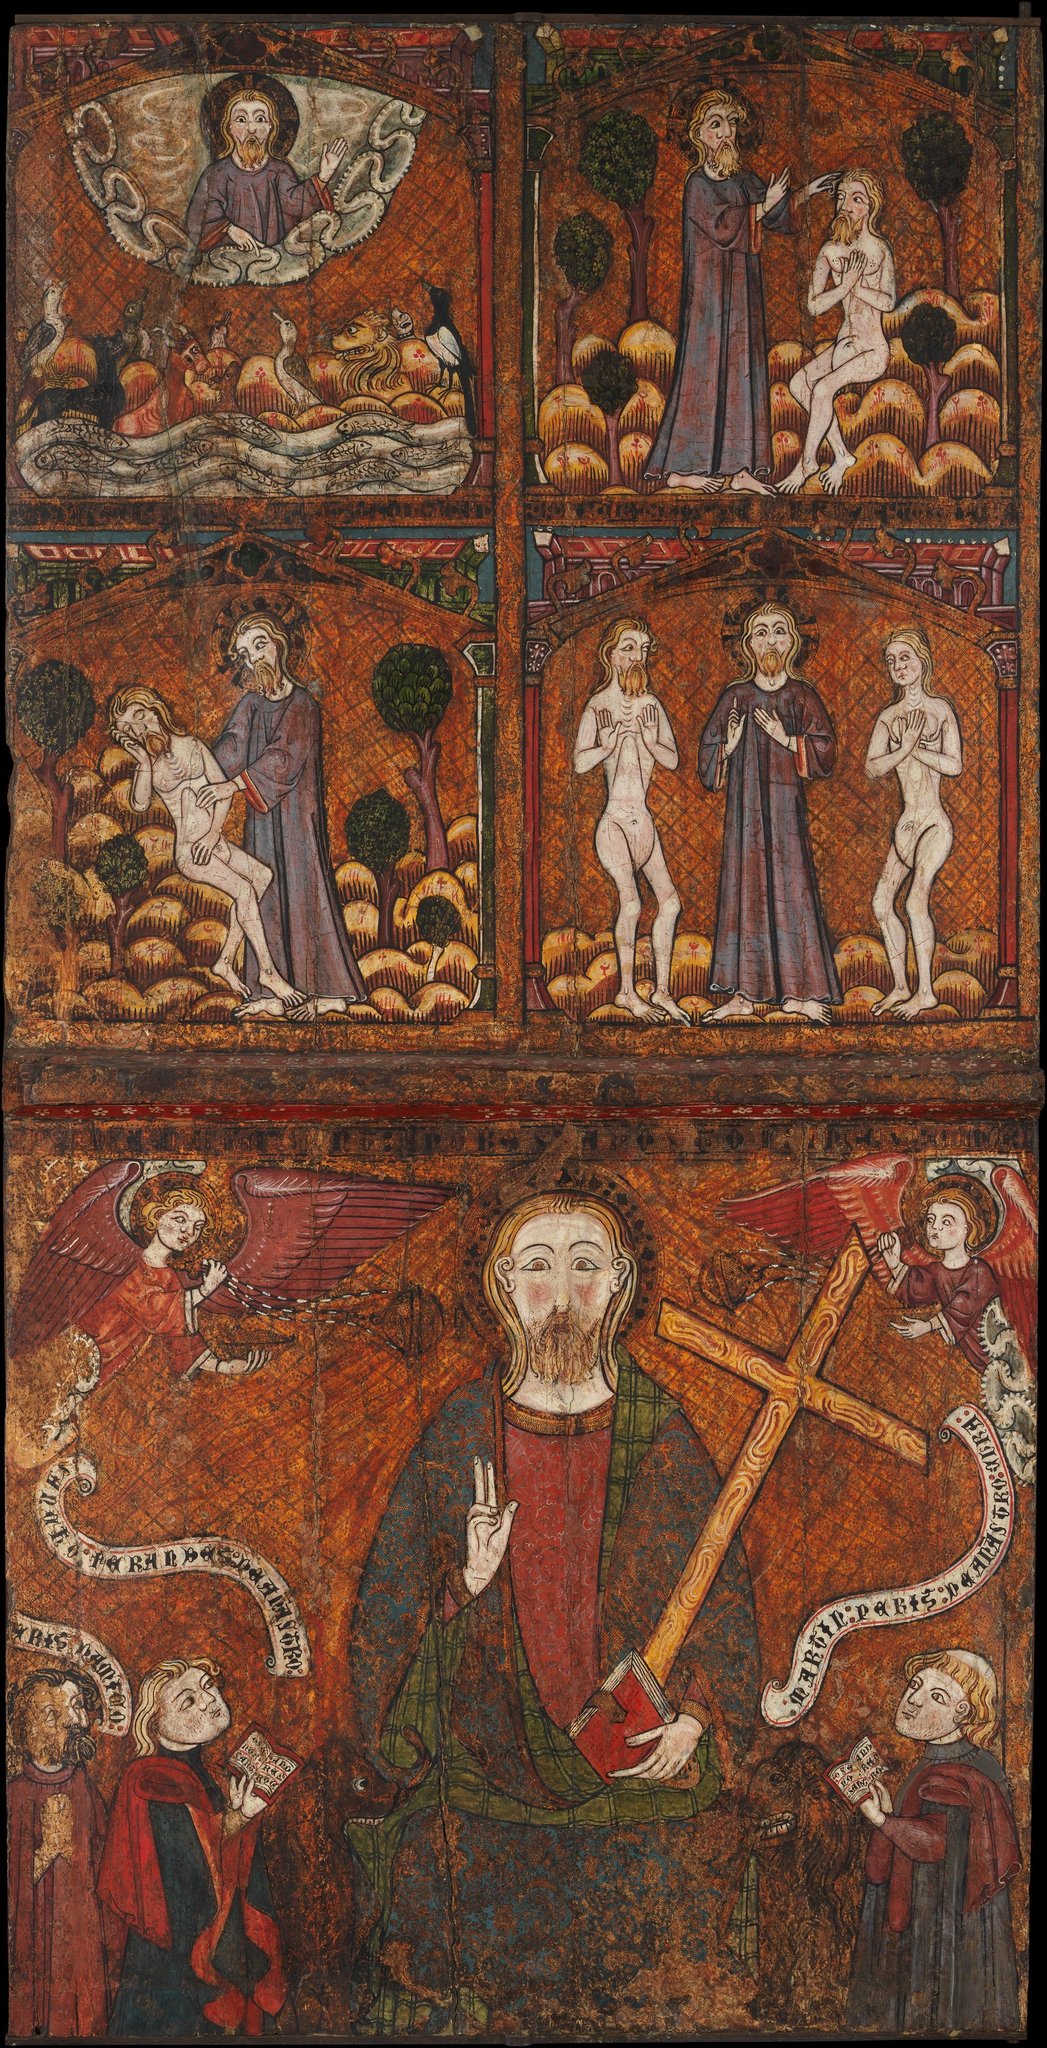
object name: altarpiece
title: Scenes from the Life of Saint Andrew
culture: spanish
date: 1367-1400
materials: gold leaf, paint, wood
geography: spain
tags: birds,dogs,angels,adam,eve,saints